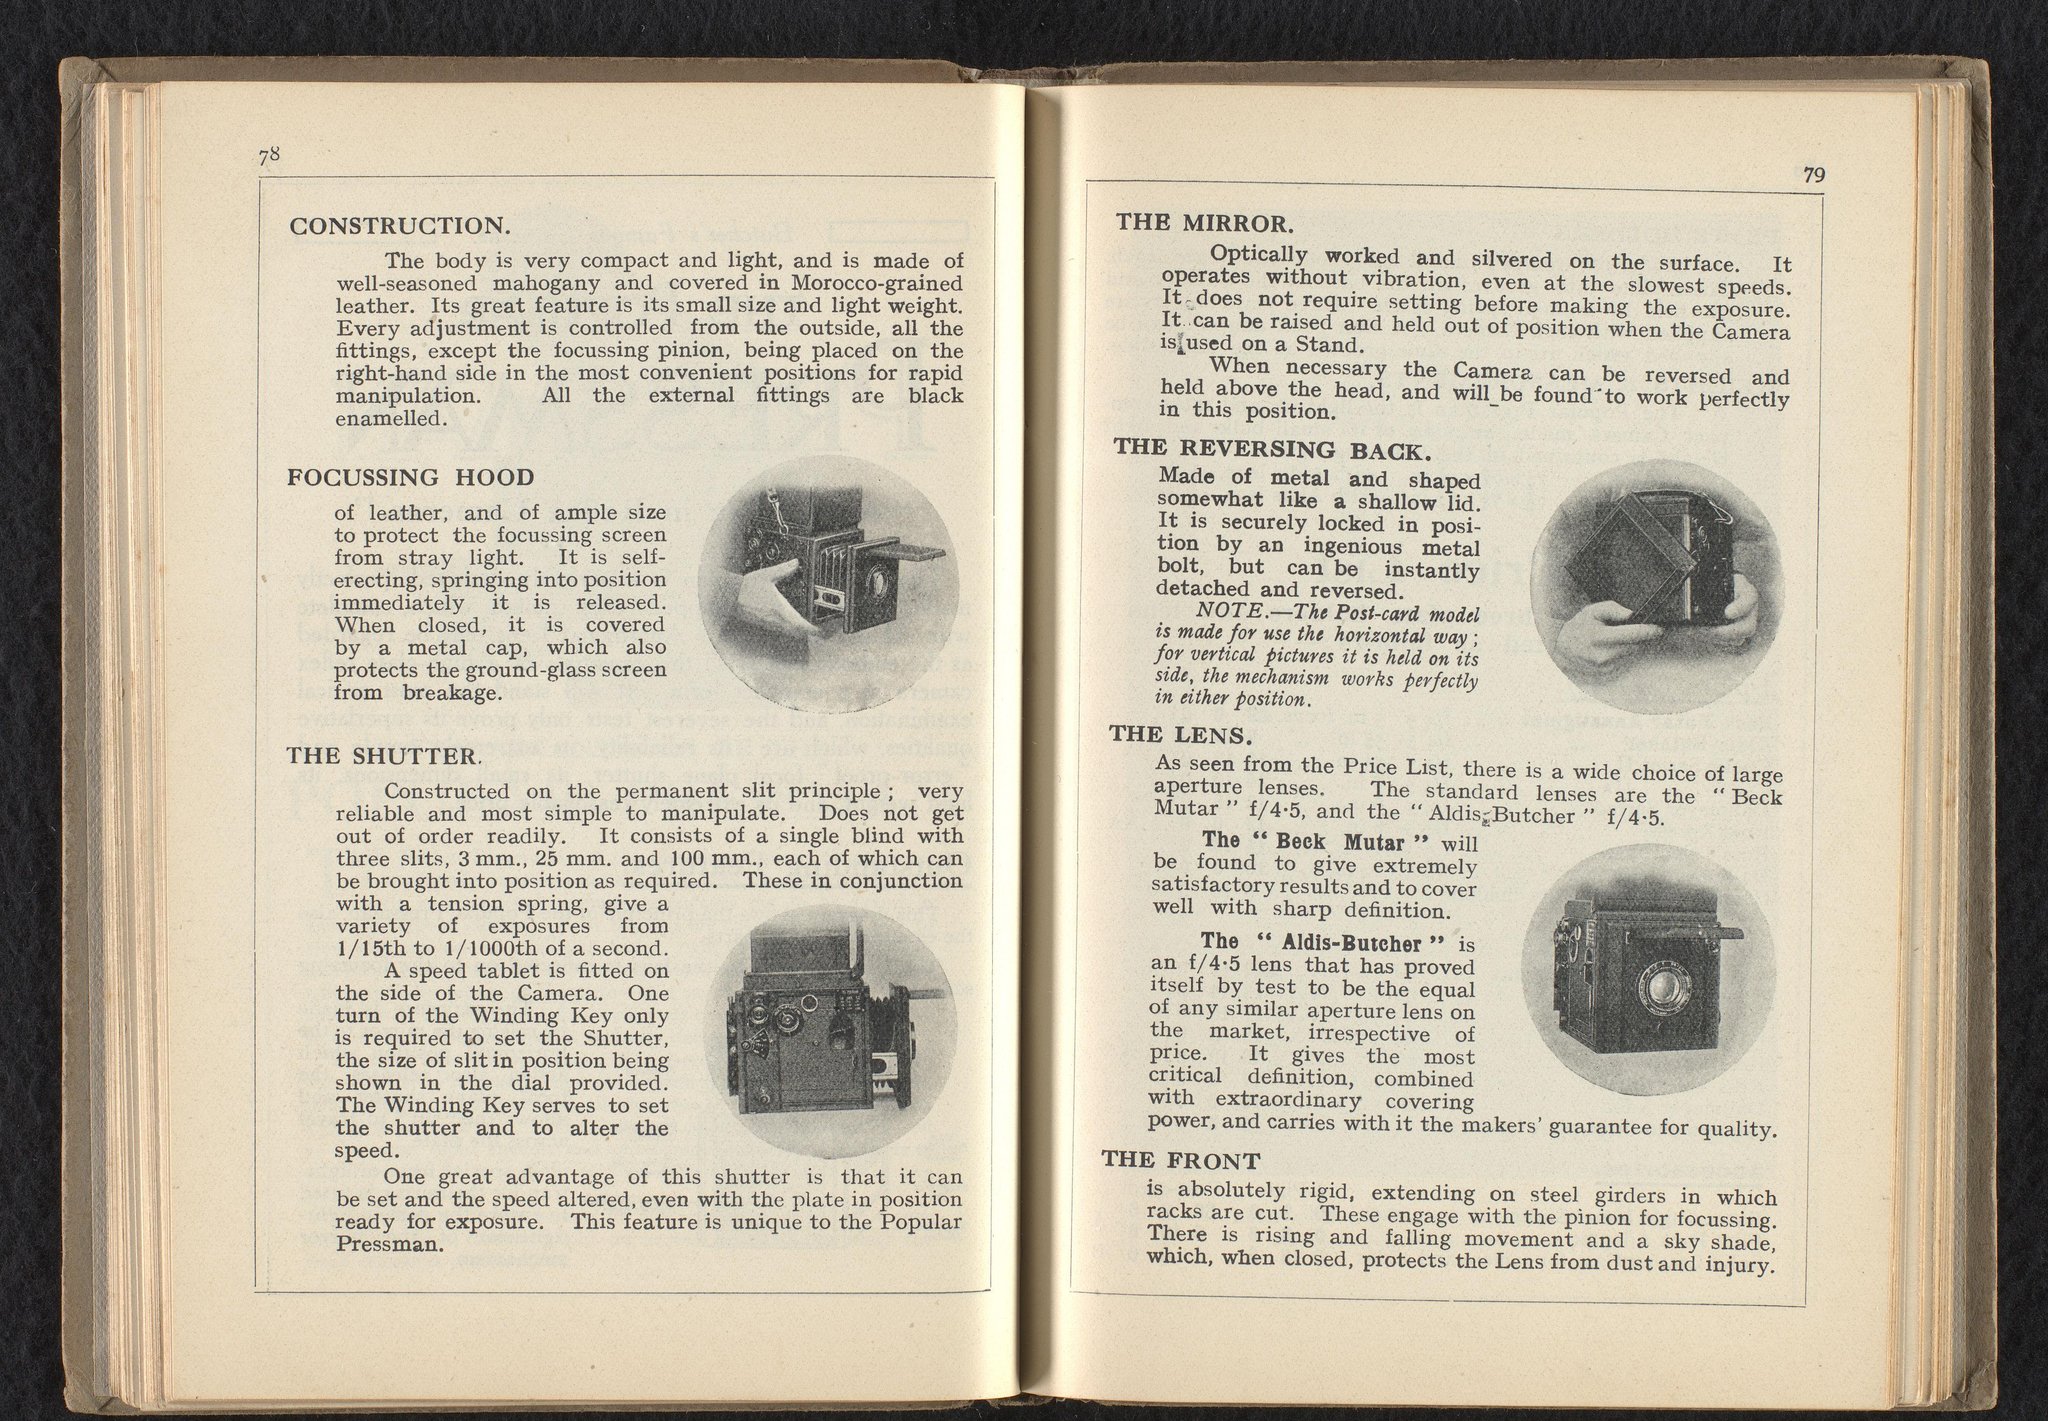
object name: page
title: Roterende achterkant en lens van de Popular Pressman Reflex Camera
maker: Anonymous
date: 1907-1912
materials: paper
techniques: letterpress printing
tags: camera ~ photography